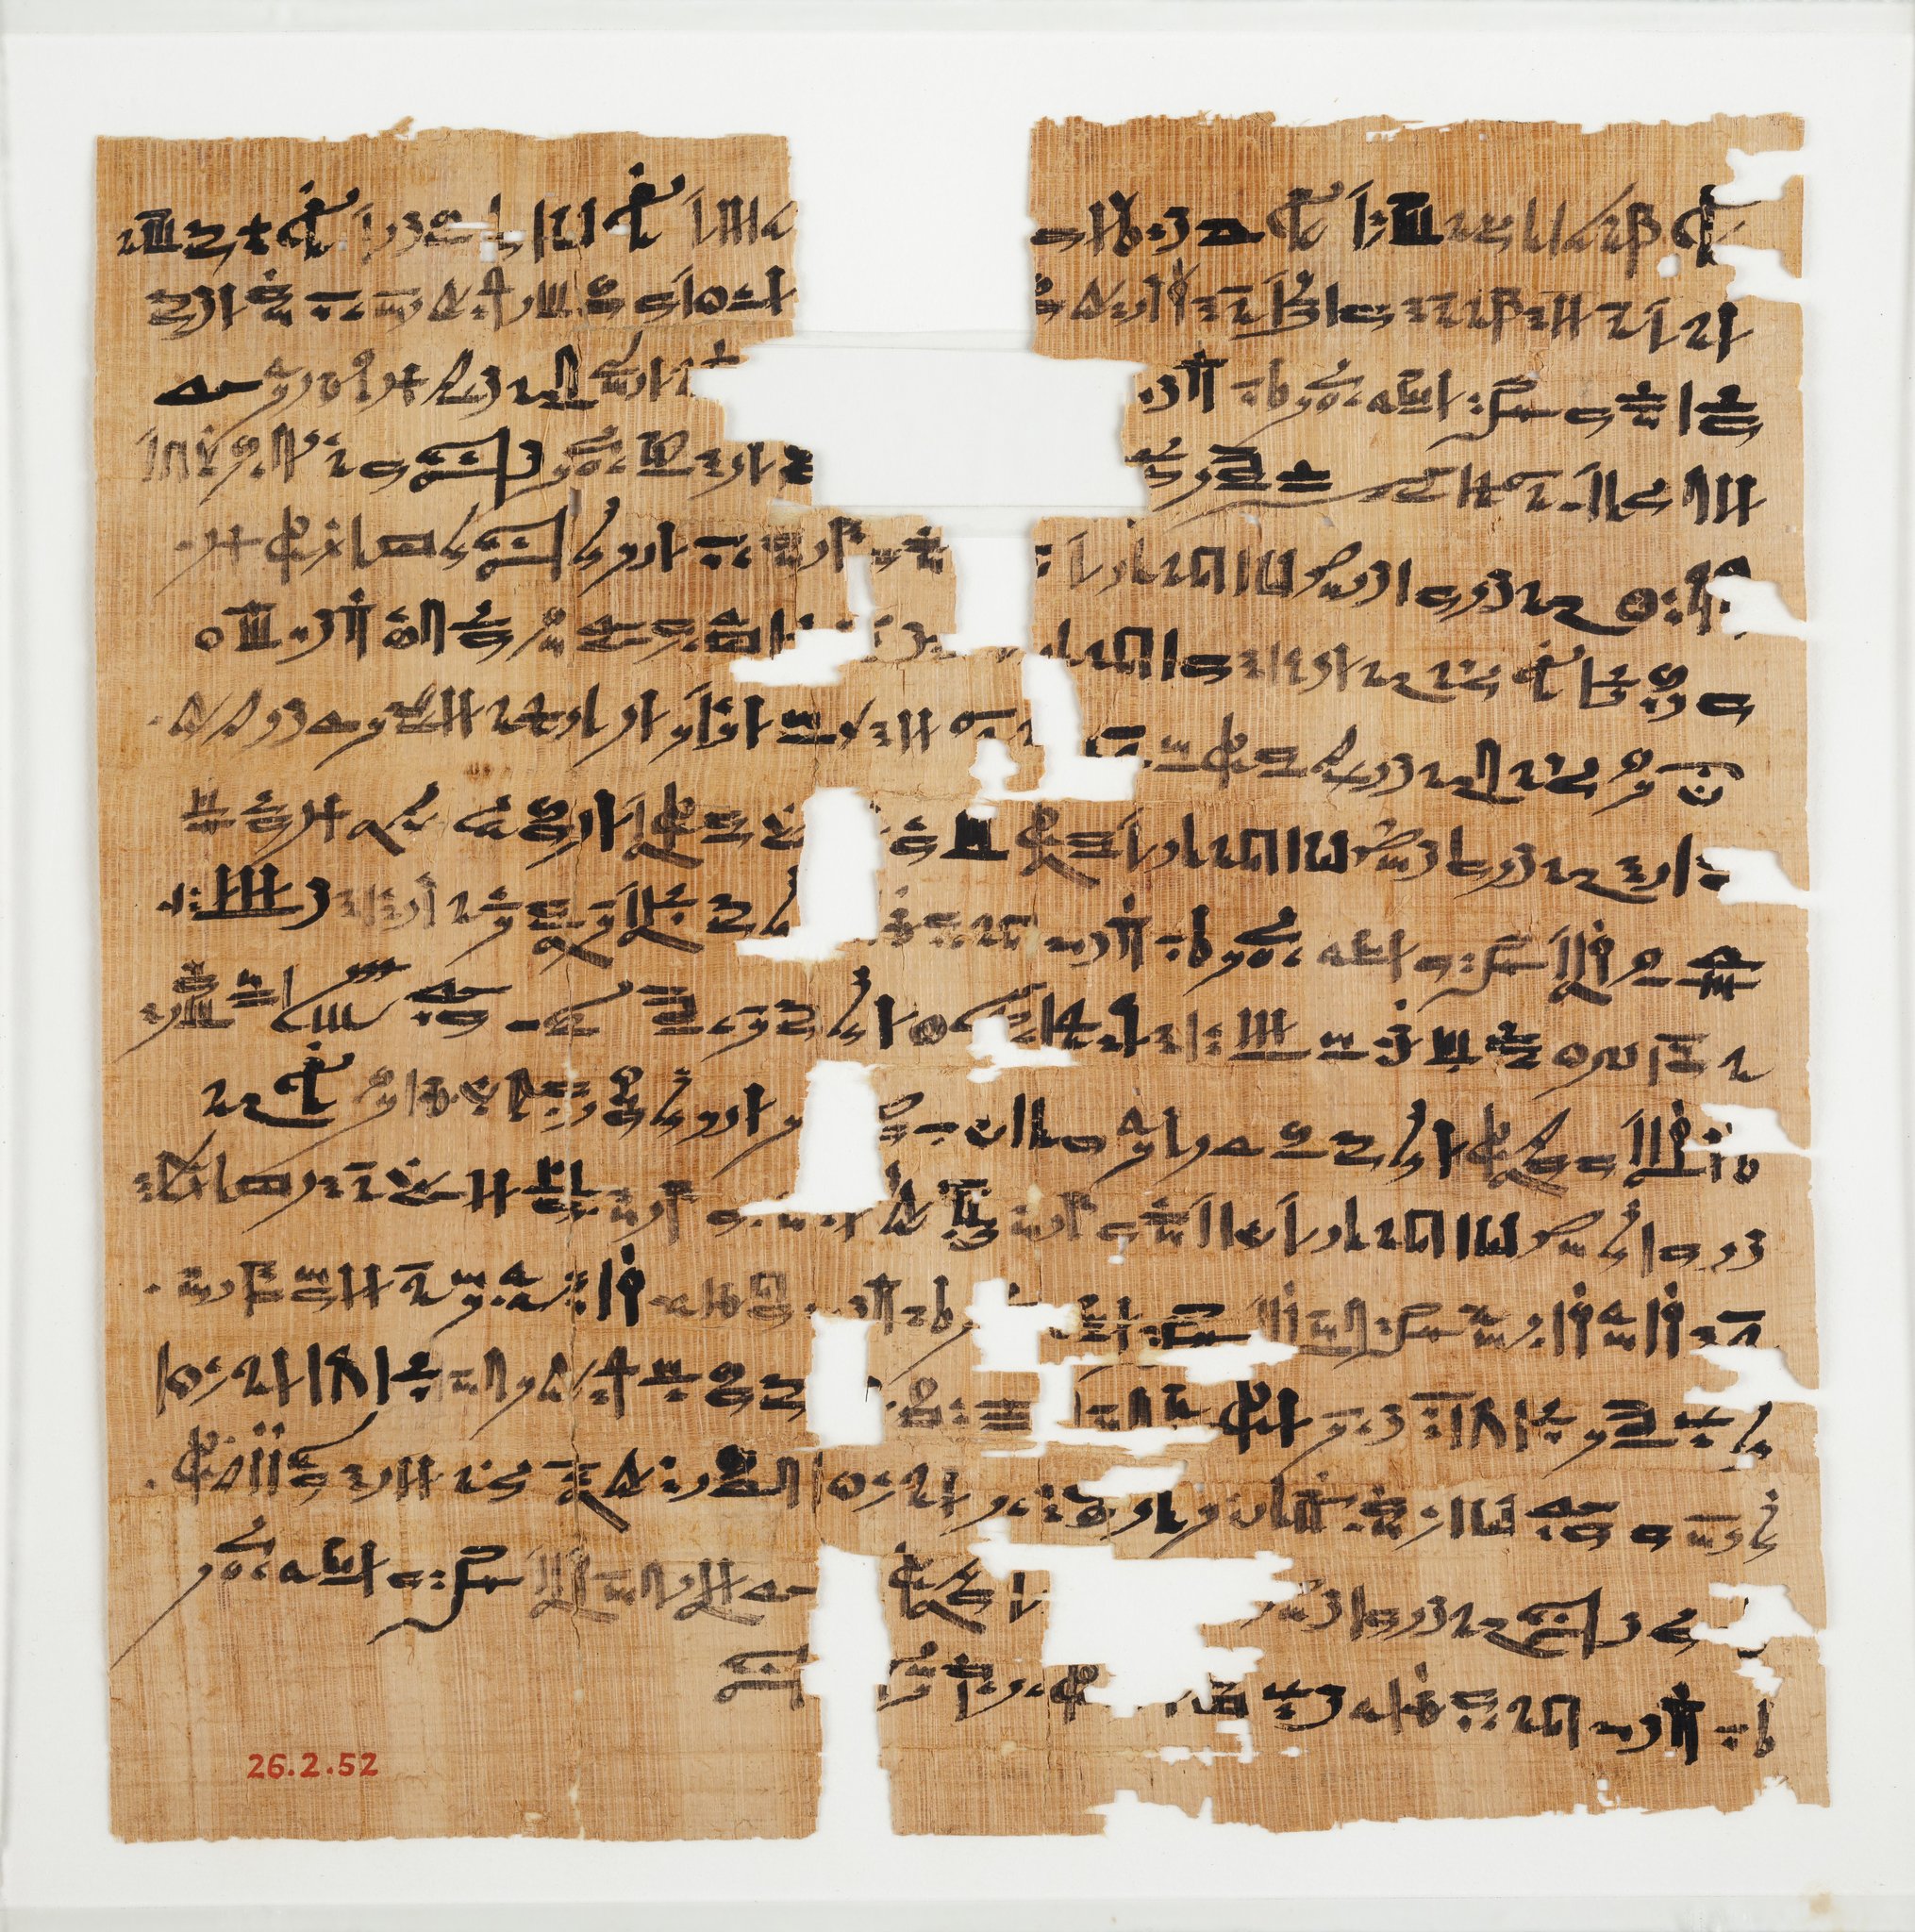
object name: papyrus, funerary, nesiamun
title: Funerary Papyrus of Nesiamun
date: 1070-945 BCE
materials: ink, papyrus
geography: upper egypt, thebes